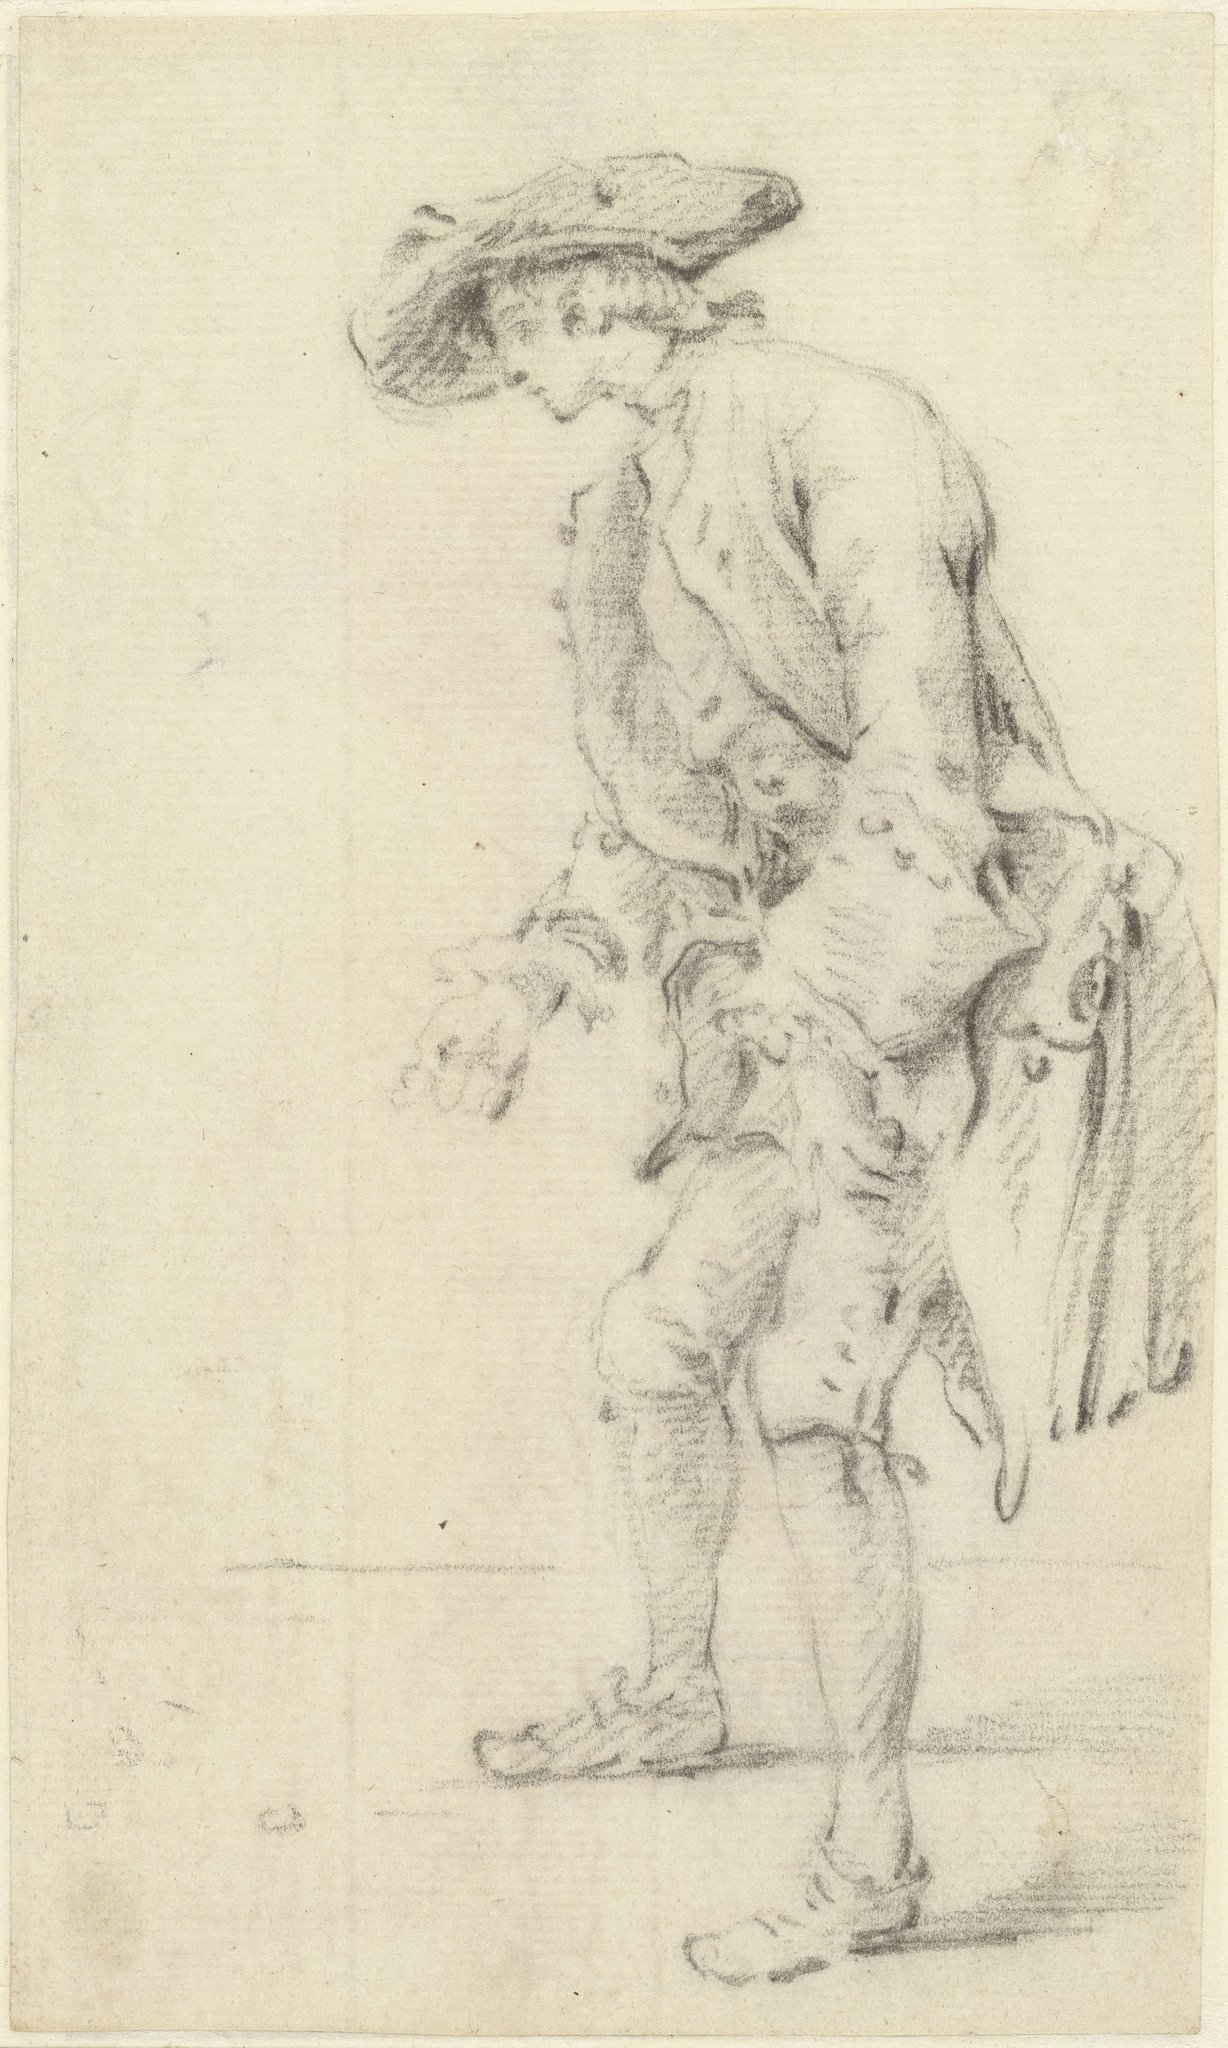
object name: drawing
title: Jonge edelman, naar links in gebogen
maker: simon fokke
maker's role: draughtsman, print maker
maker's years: 1712-1784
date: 1710-1779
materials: chalk, paper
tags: standing figure